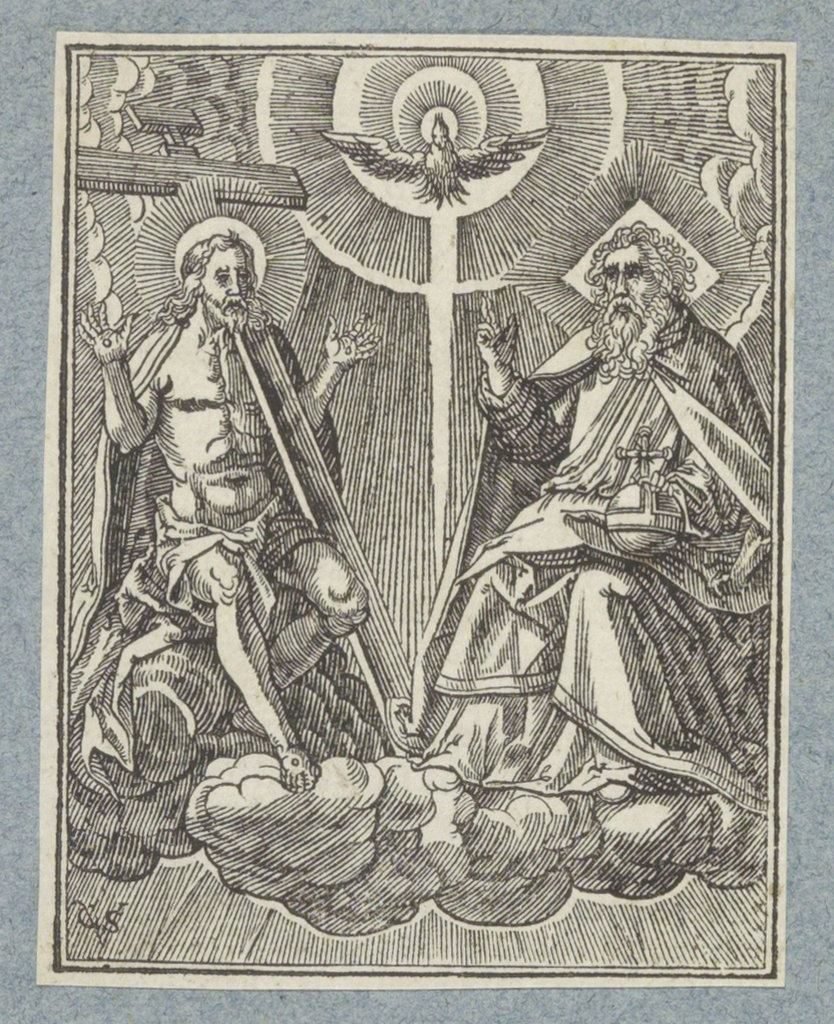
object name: album leaf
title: Drie-eenheid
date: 1629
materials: paper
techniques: letterpress printing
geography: amsterdam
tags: trinity in which god the father and christ are represented as persons, the holy ghost as dove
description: De prent is afkomstig uit een van de uitgaven van P.J. Paets uit Amsterdam. De prent wordt voor het eerst gebruikt in: Der Zielen Lust-hof. Leuven, I.Jacbosz voor P.J. Paets [= Amsterdam, P.J. Paets], 1629.